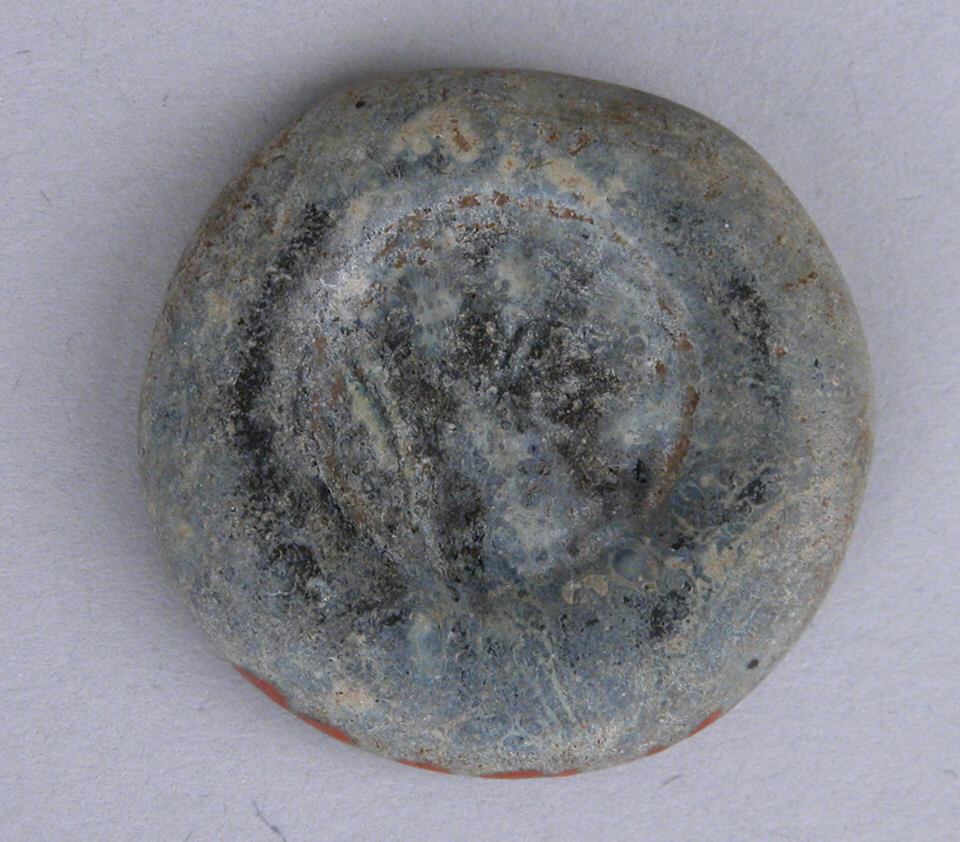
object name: coin weight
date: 801-1000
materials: glass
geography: egypt